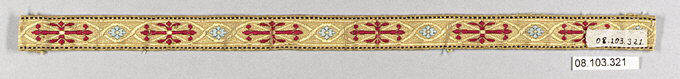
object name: galloon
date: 1801-1900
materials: silk